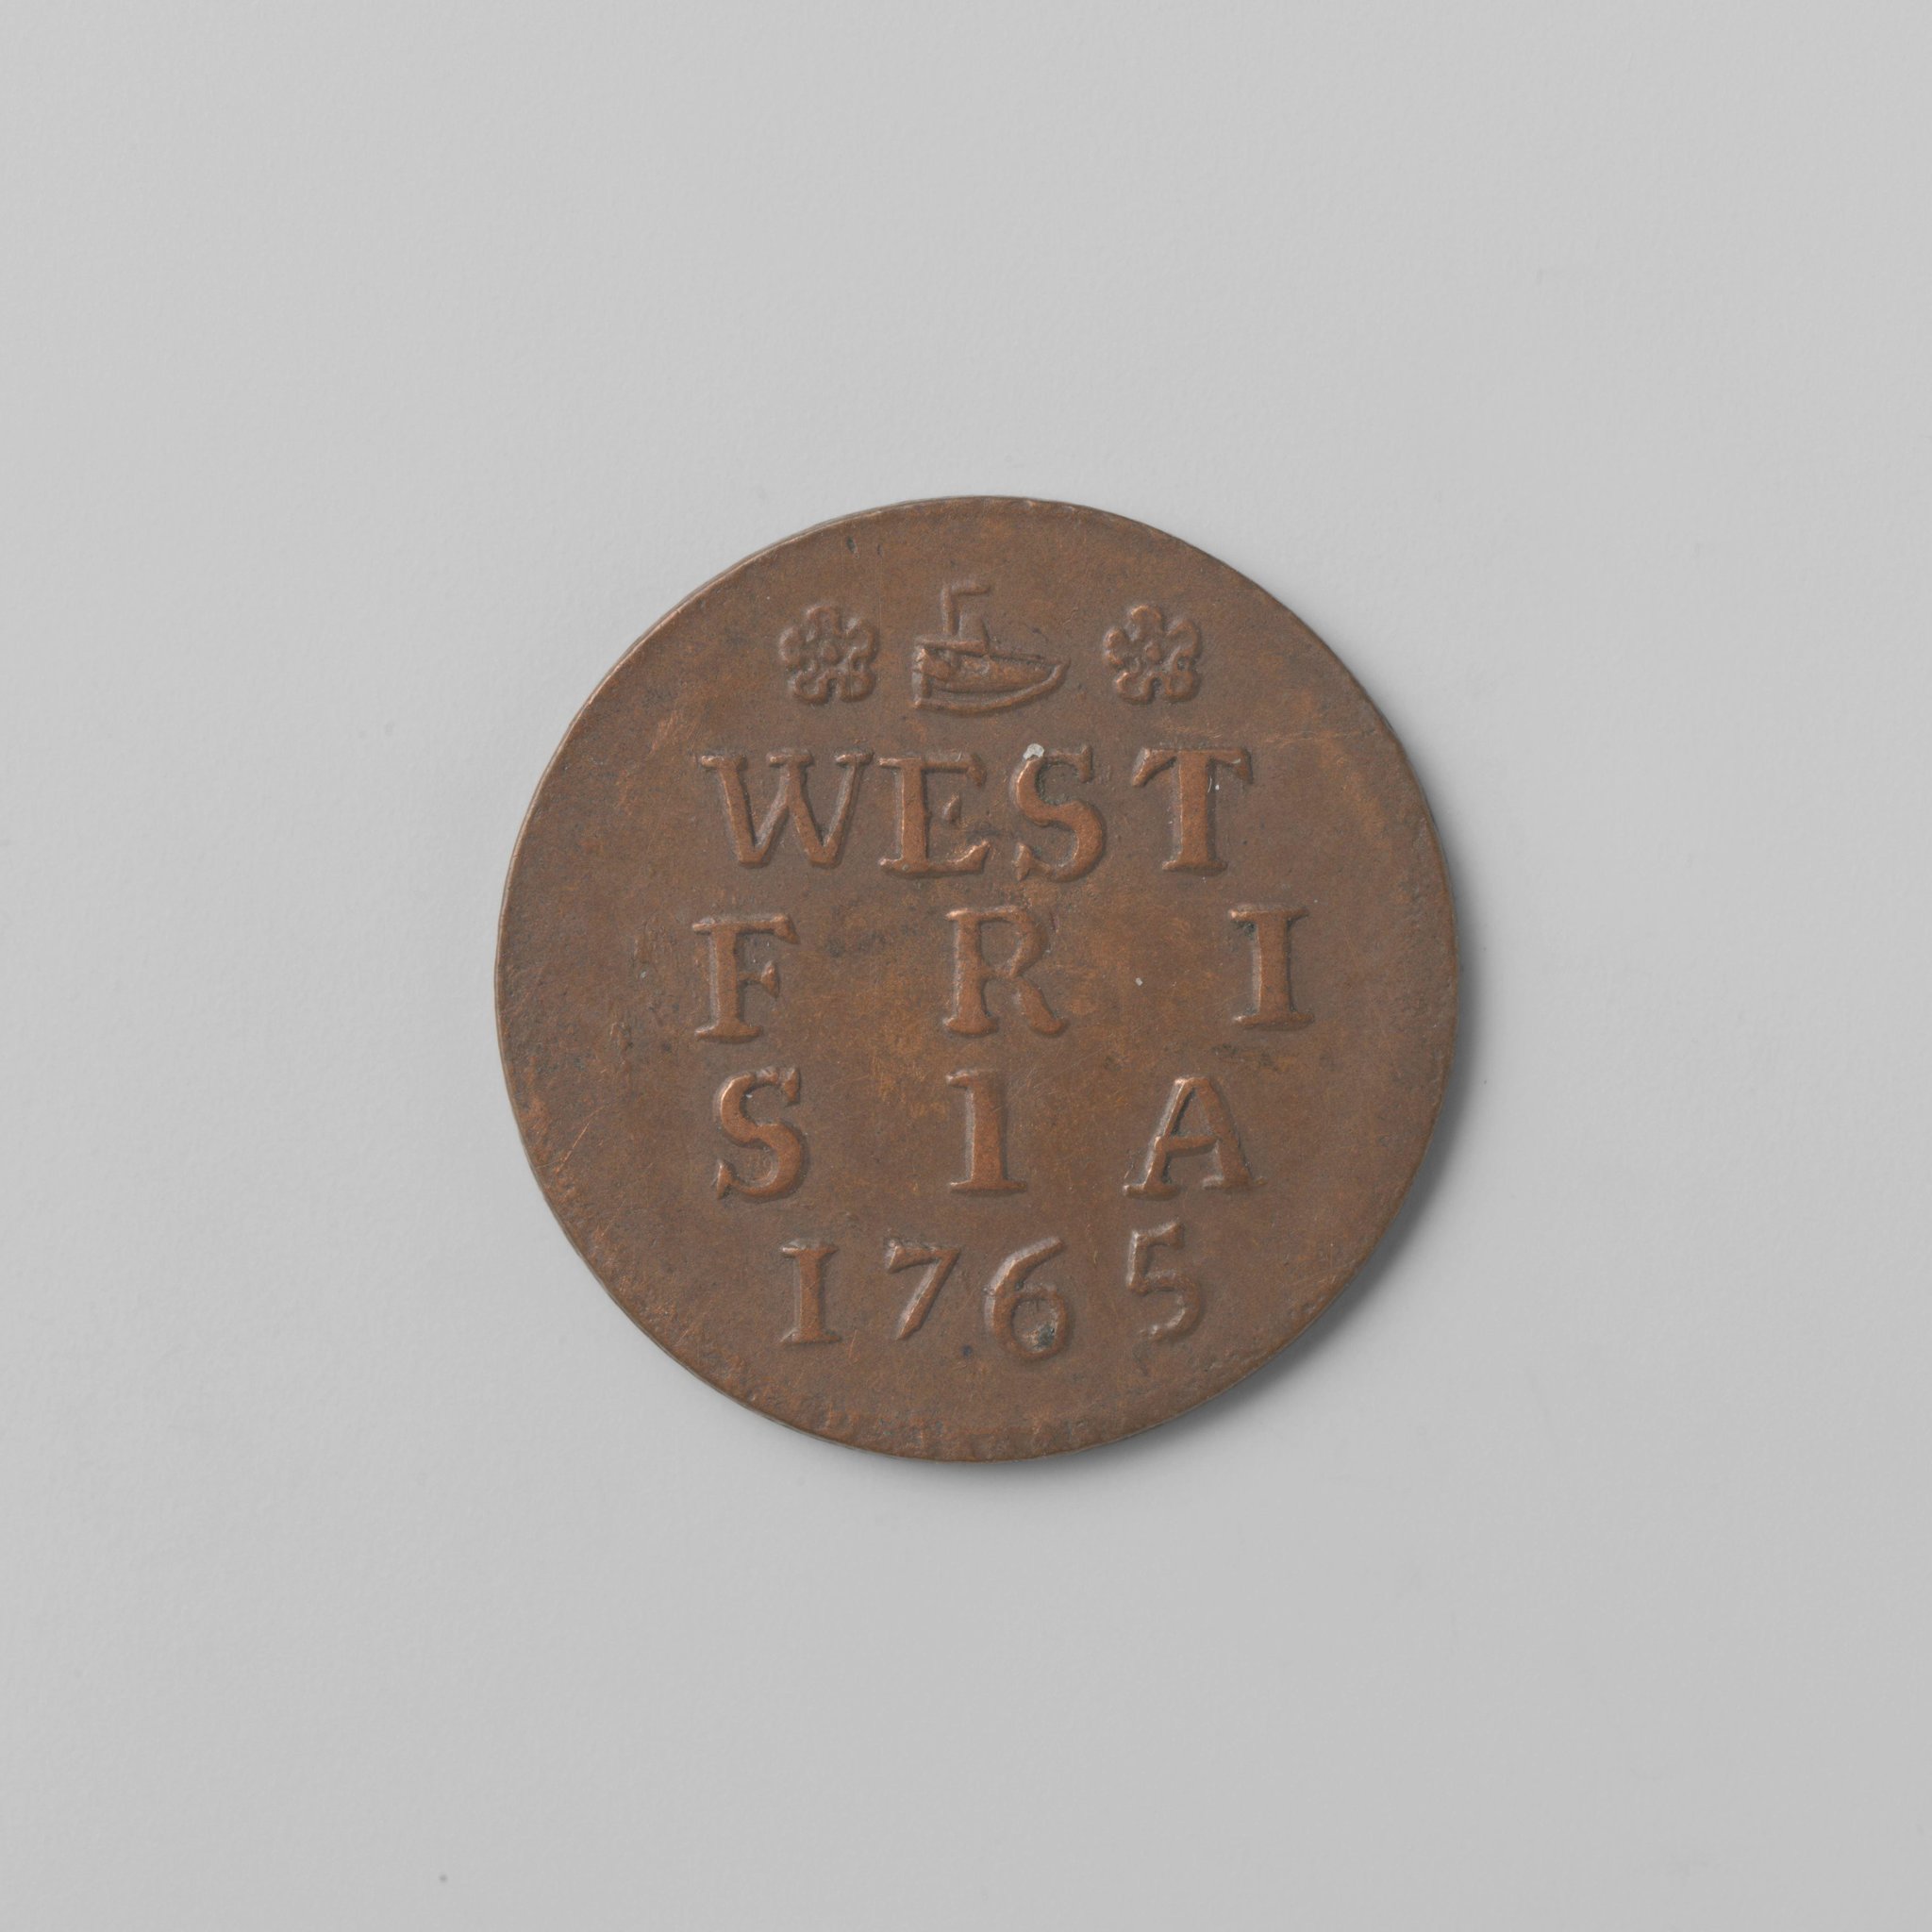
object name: coin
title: Westfriese duit, 1765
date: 1765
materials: copper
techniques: striking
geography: west frisia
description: Koperen munt. Voorzijde: gekroond wapenschild van West-Friesland met lauwertakken. Keerzijde: opschrift in drie regels. Daarboven muntmeesterteken haringbuis tussen twee rozetten. Daaronder jaartal.